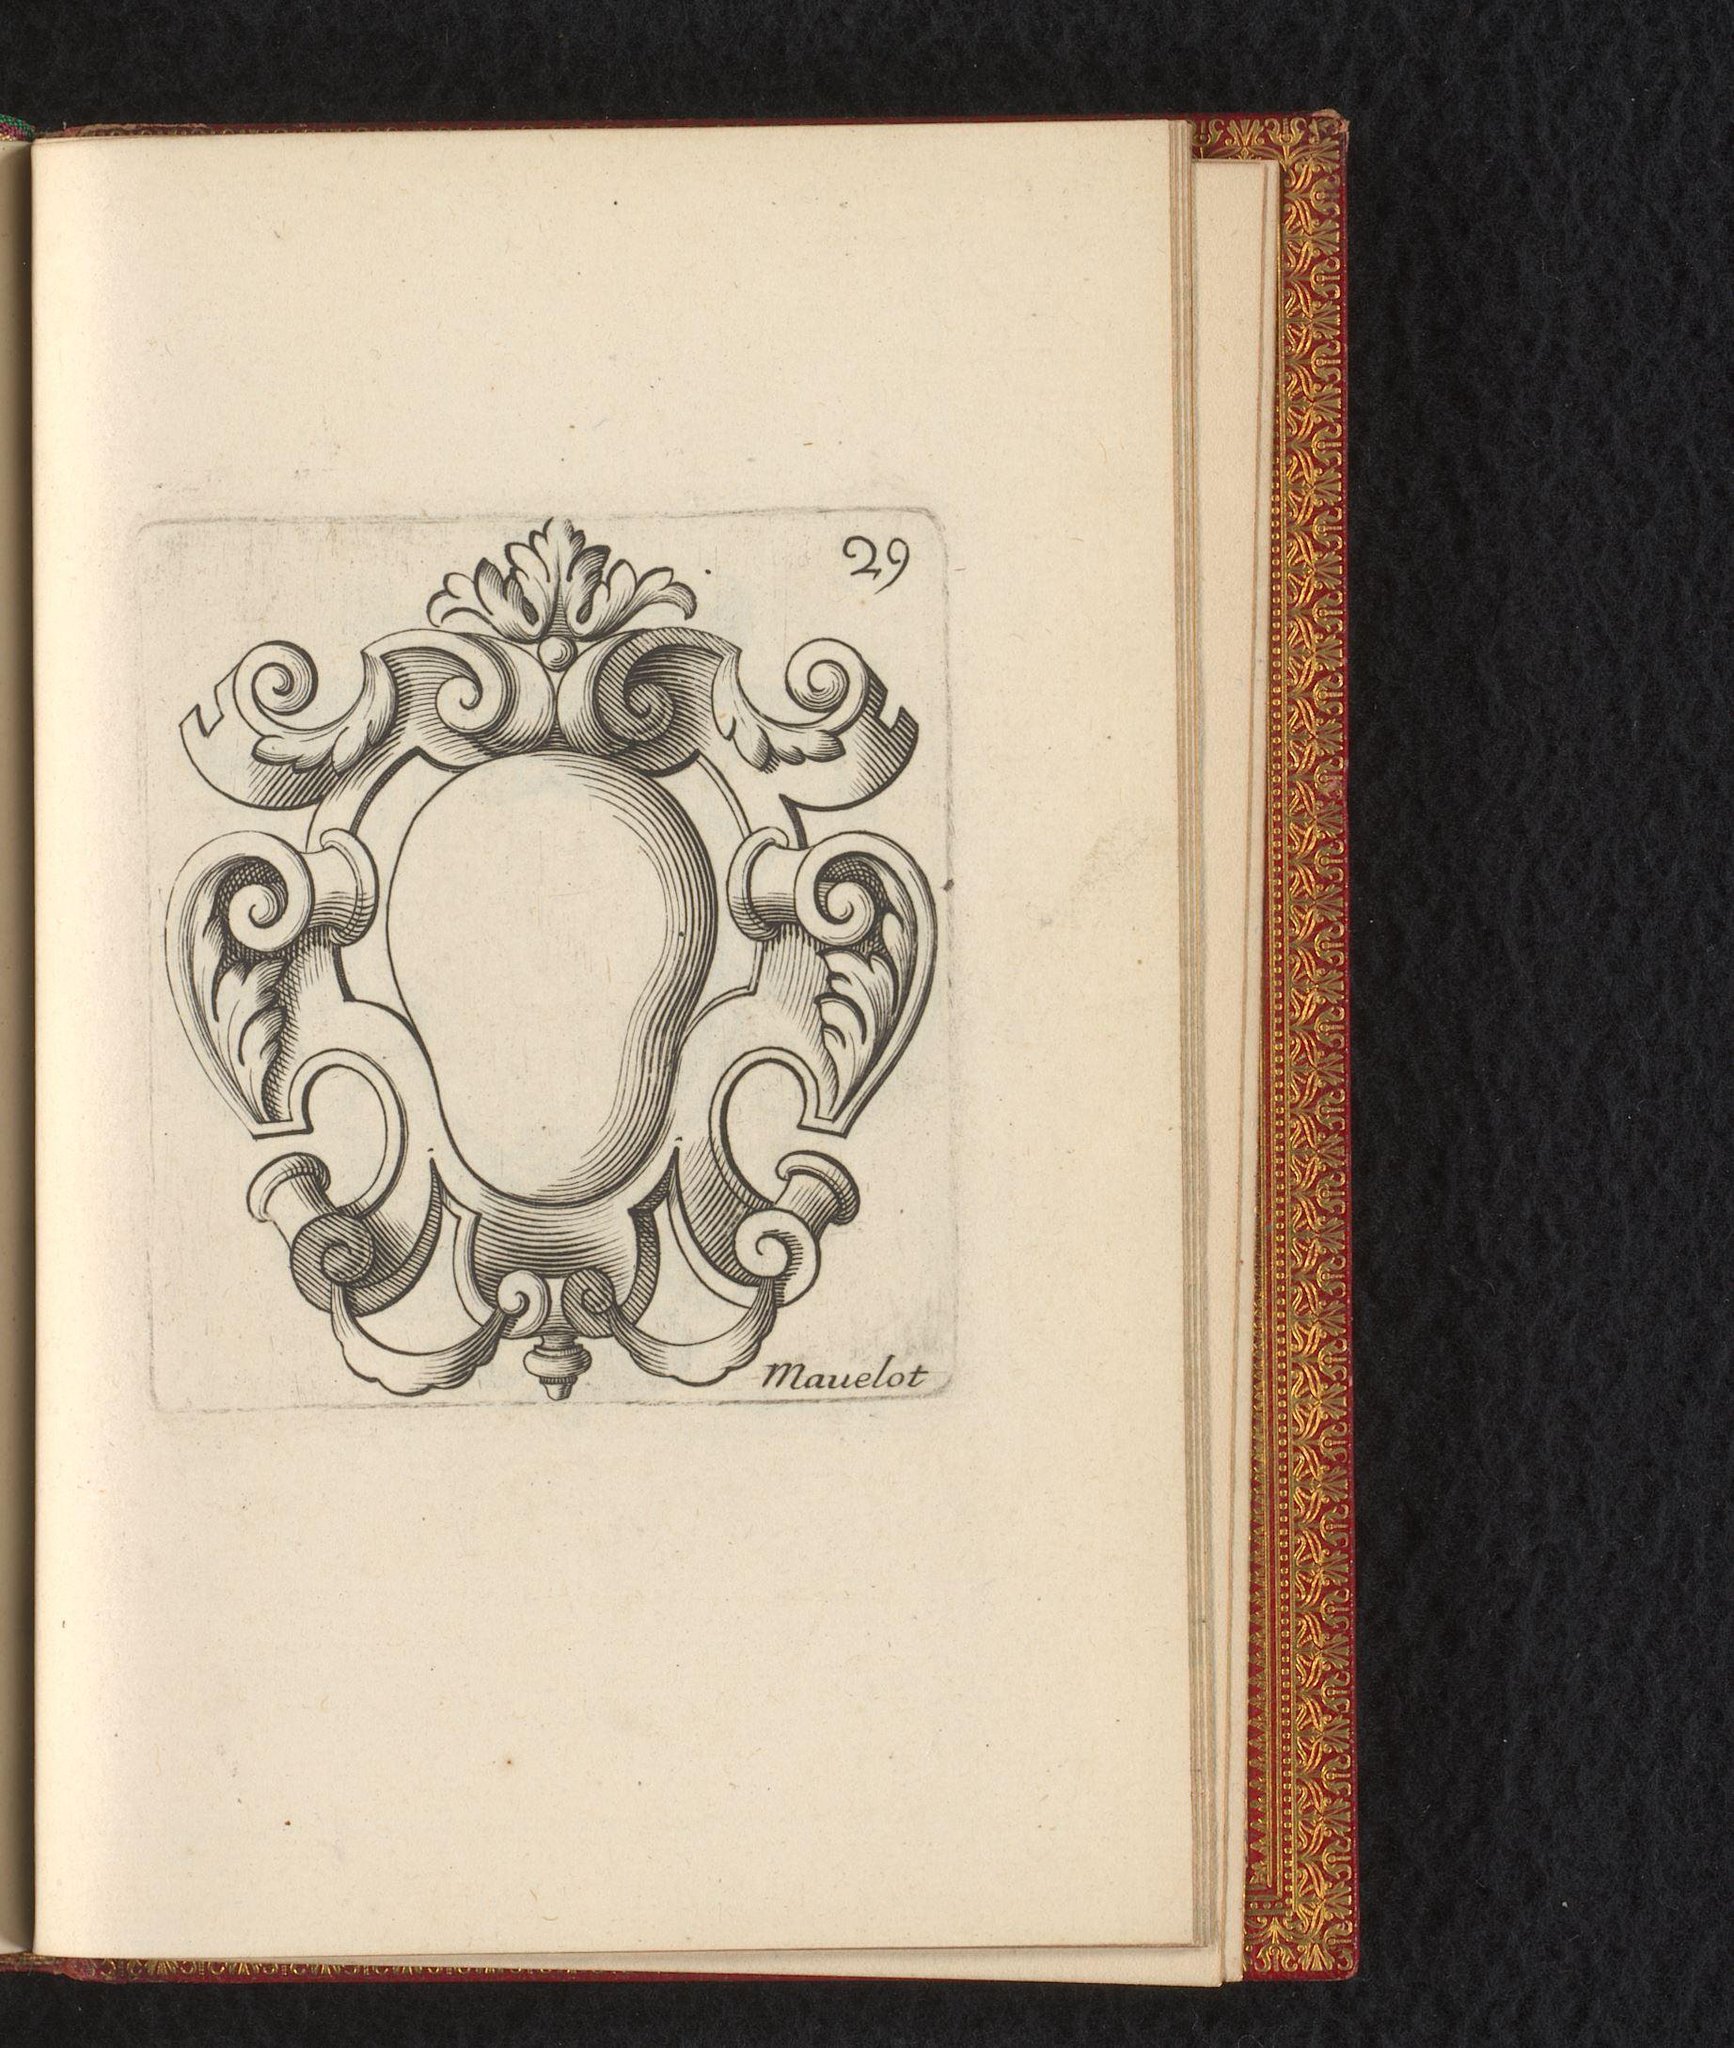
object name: print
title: Cartouche met rolwerk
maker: charles mavelot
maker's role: draughtsman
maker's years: 1680-1742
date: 1685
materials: paper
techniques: engraving, etching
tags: scrollwork, strapwork ~ ornament, ornament ~ cartouche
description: Rechtsboven genummerd: 29. Prent maakt deel uit van een album.